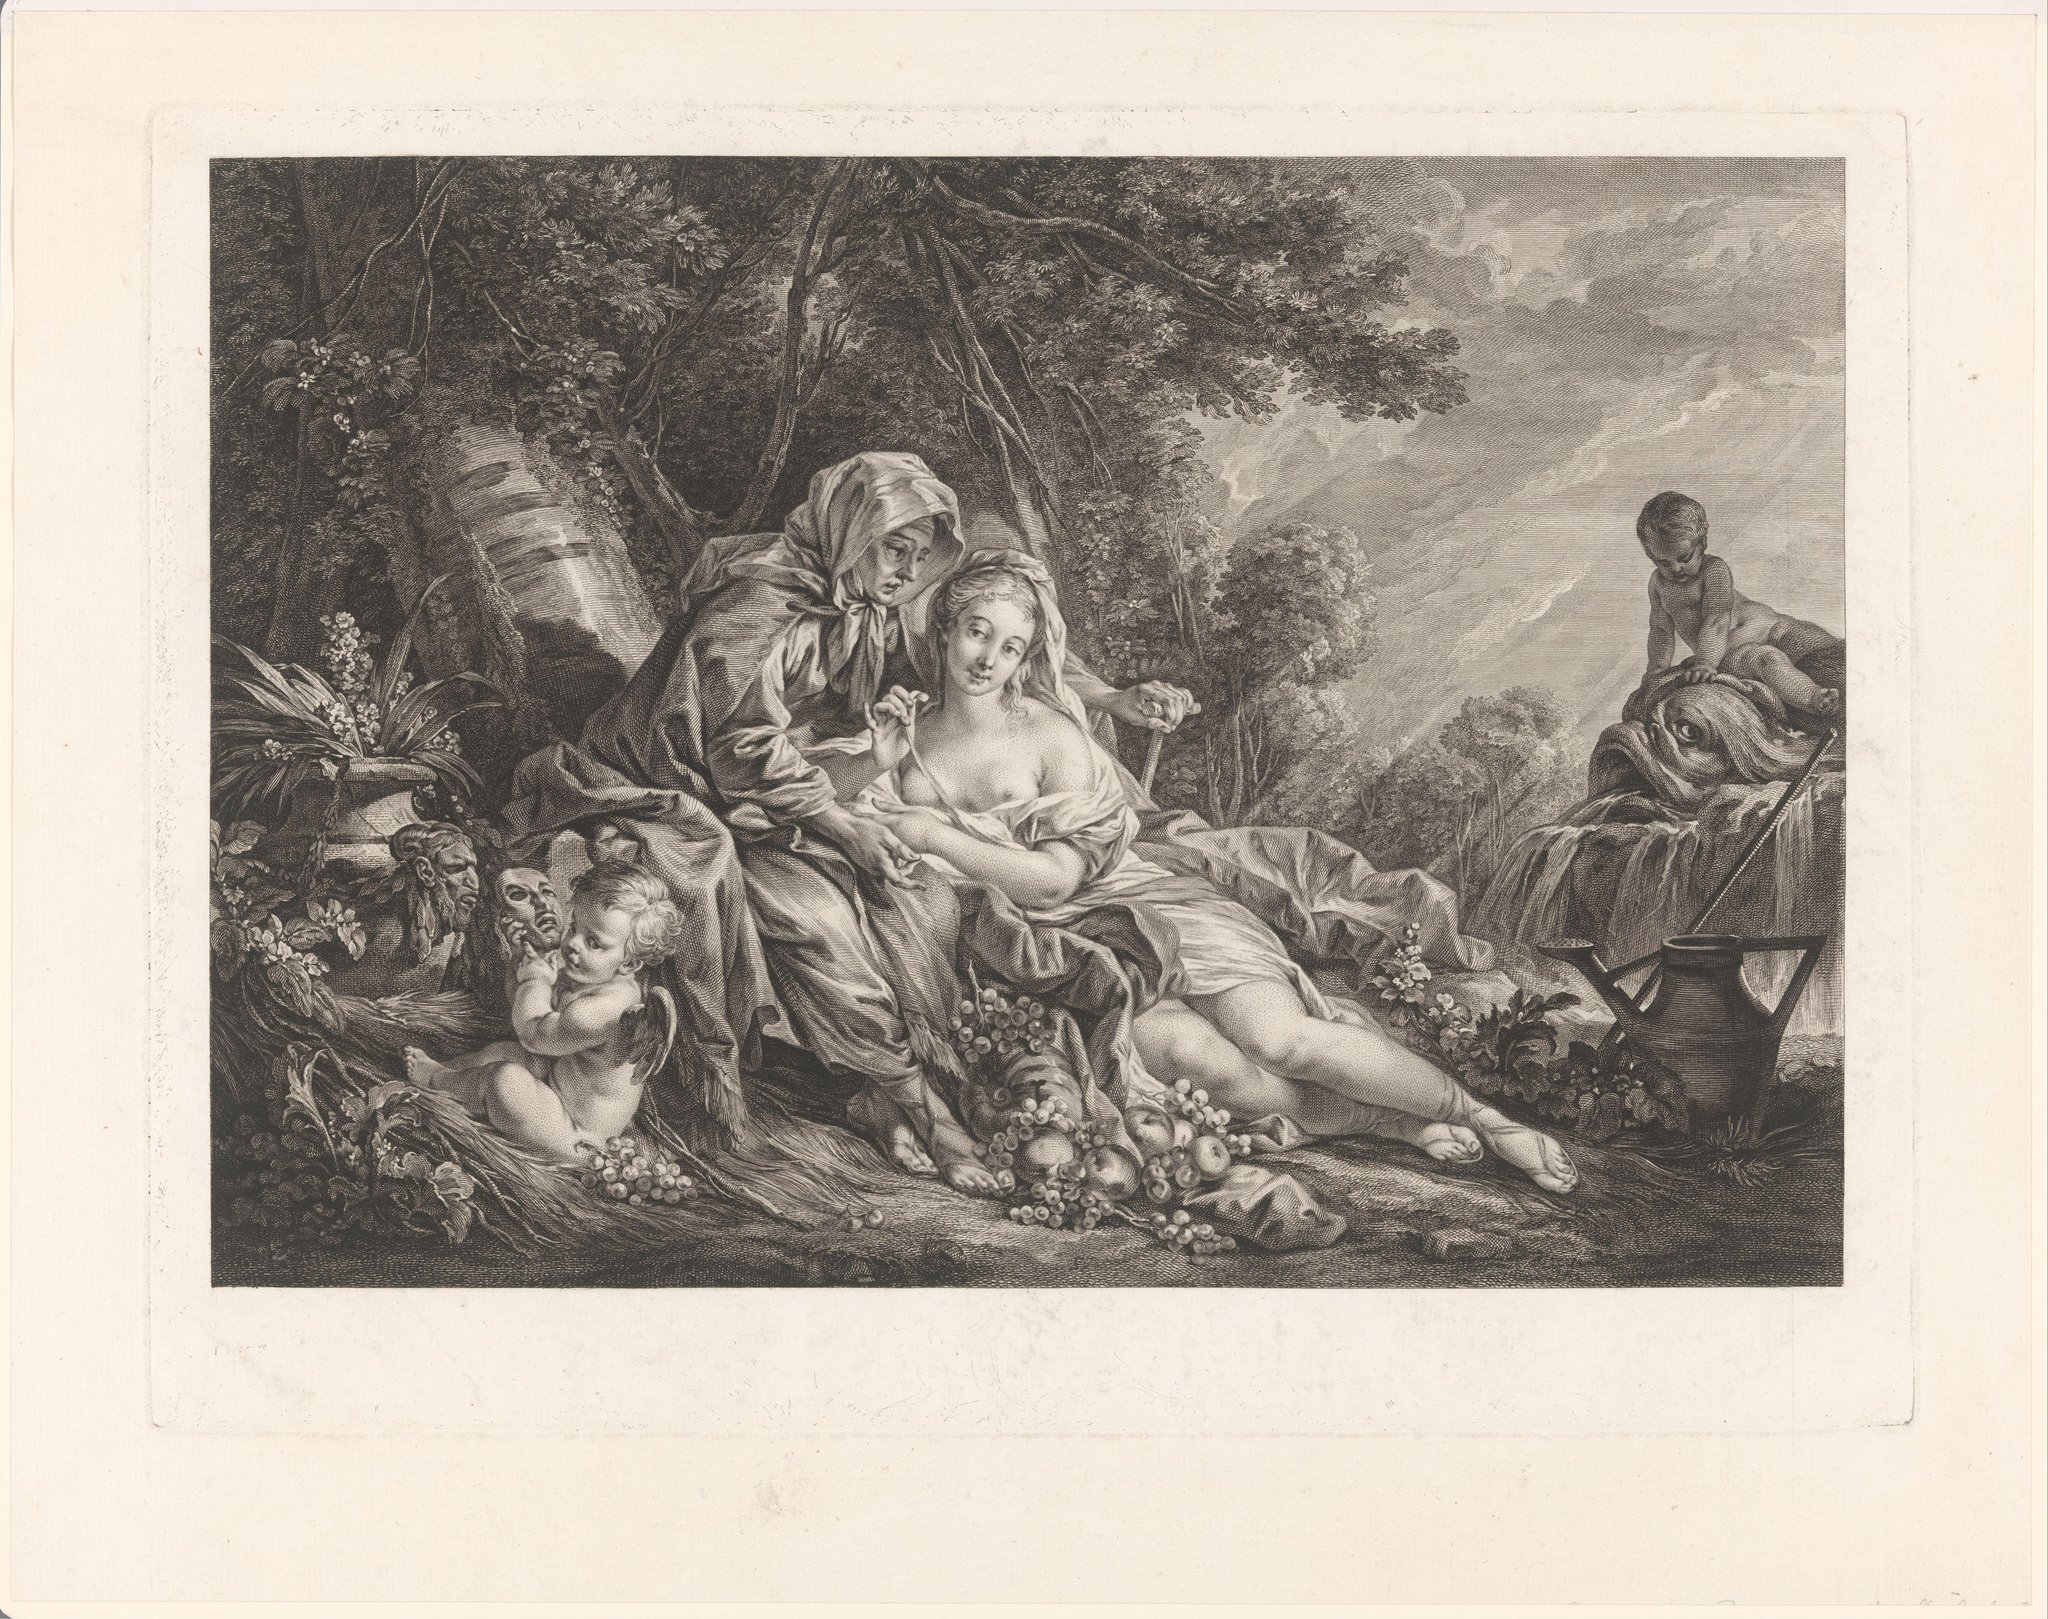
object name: print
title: Vertumnus en Pomona in een parklandschap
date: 1765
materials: paper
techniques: engraving, etching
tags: vertumnus and pomona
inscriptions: collector's mark: Lugt 240